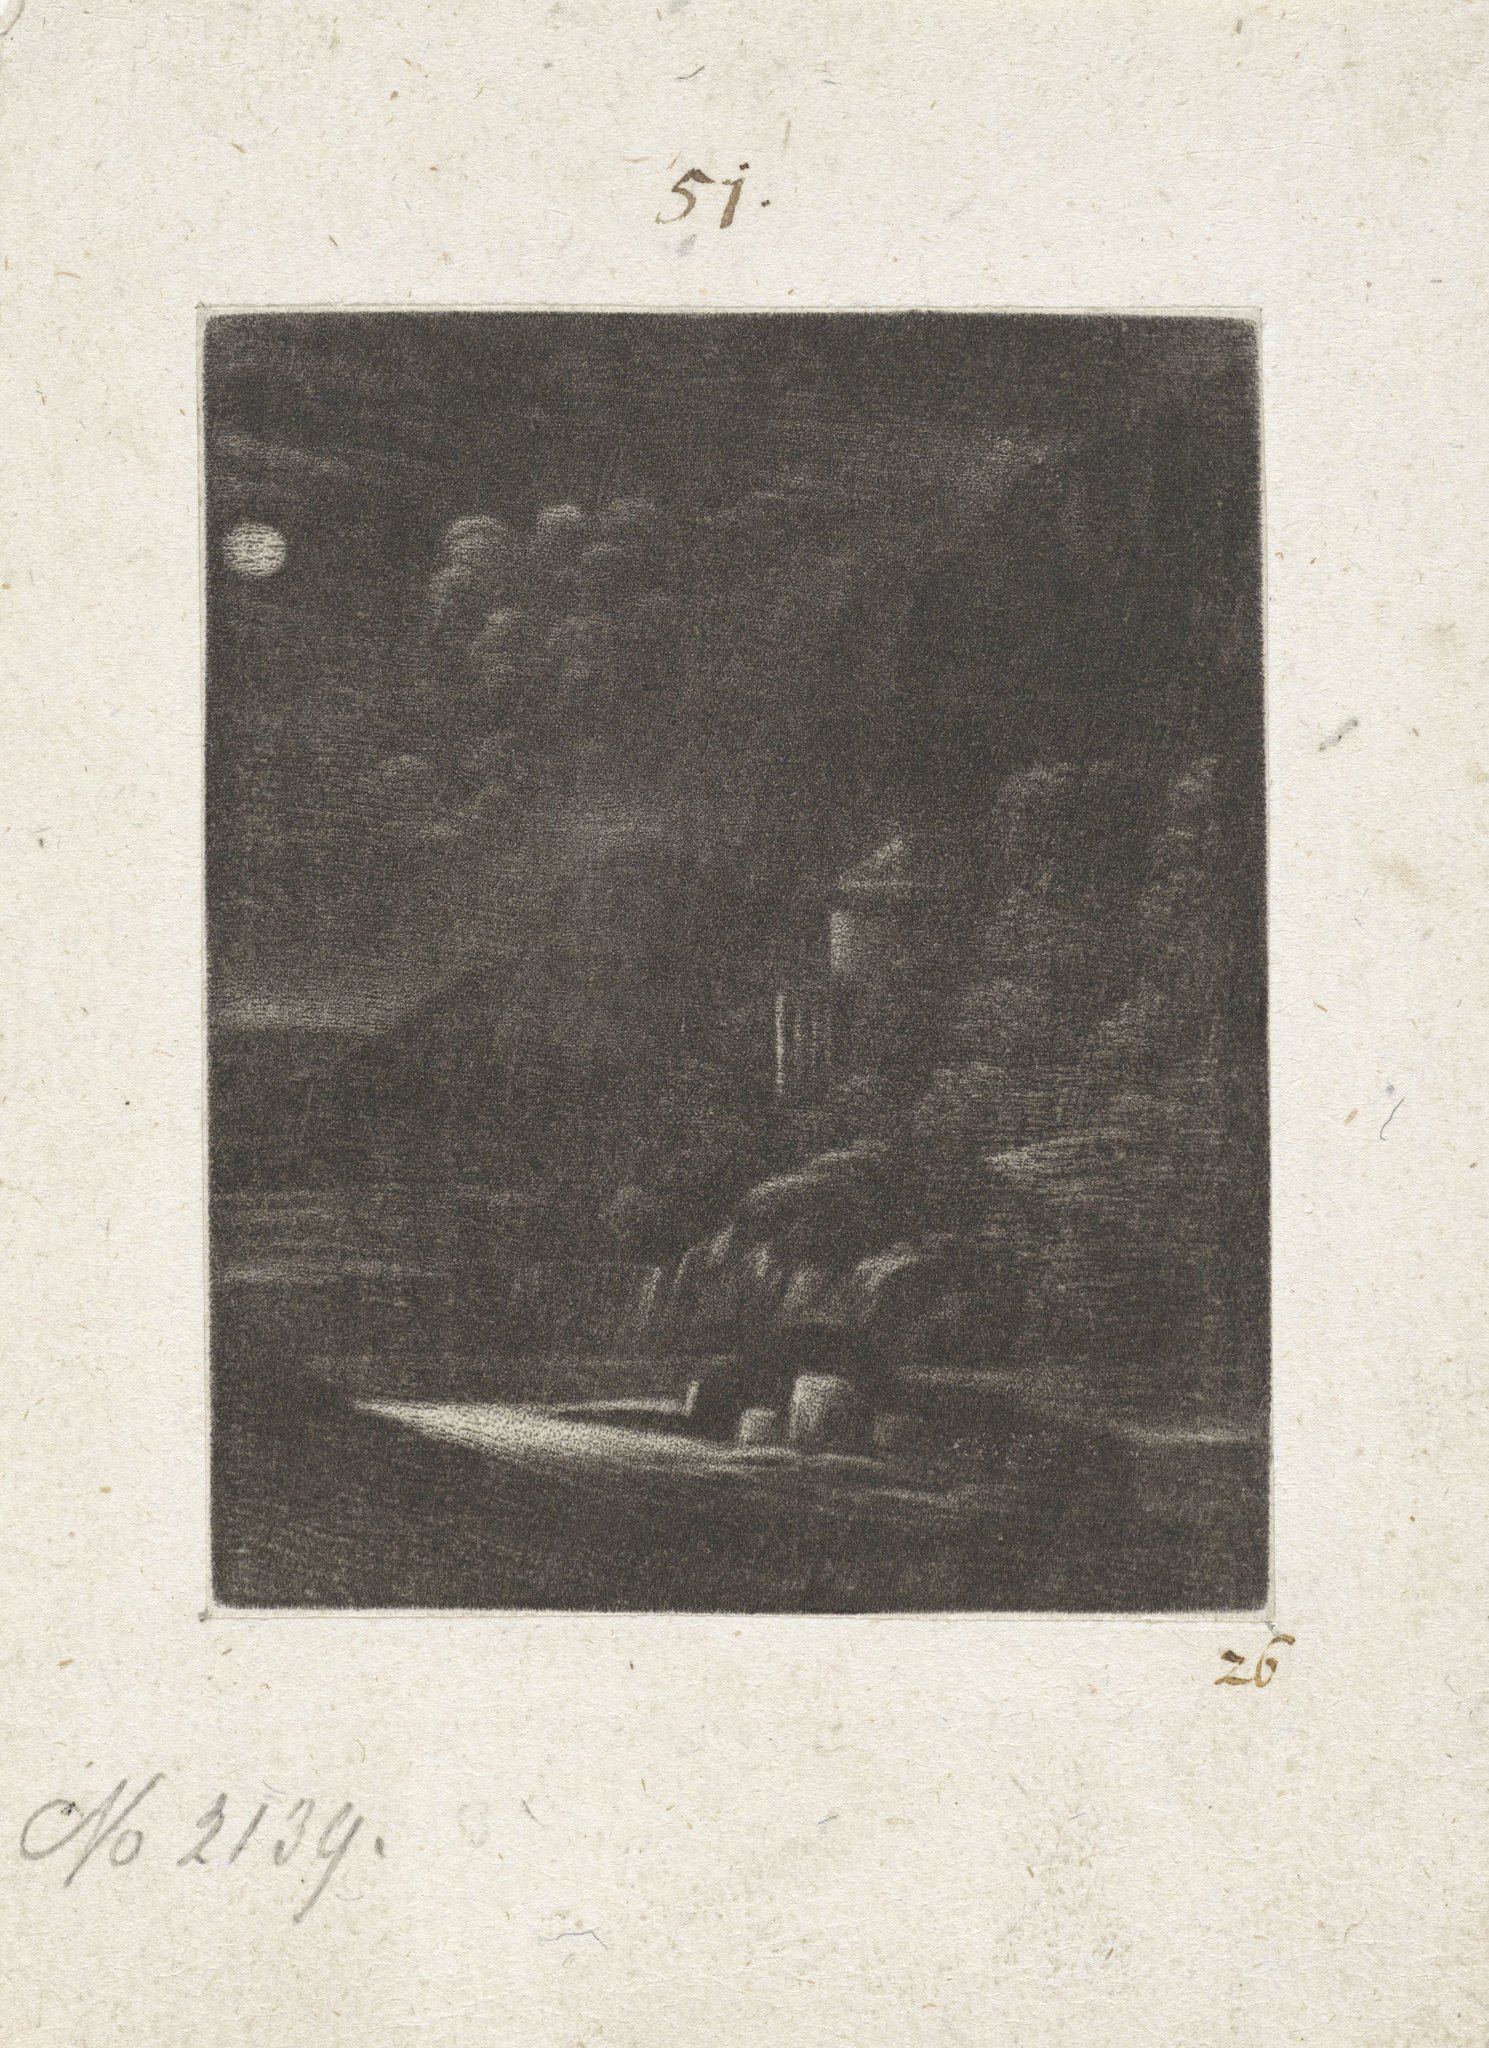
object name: print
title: Landschap bij nacht met volle maan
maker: wallerant vaillant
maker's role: draughtsman, painter, print maker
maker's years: 1623-1677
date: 1658-1677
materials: paper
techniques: mezzotint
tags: full moon, night ~ landscape (sometimes titled 'nox')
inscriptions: collector's mark: Lugt 2760, collector's mark: Lugt 2228